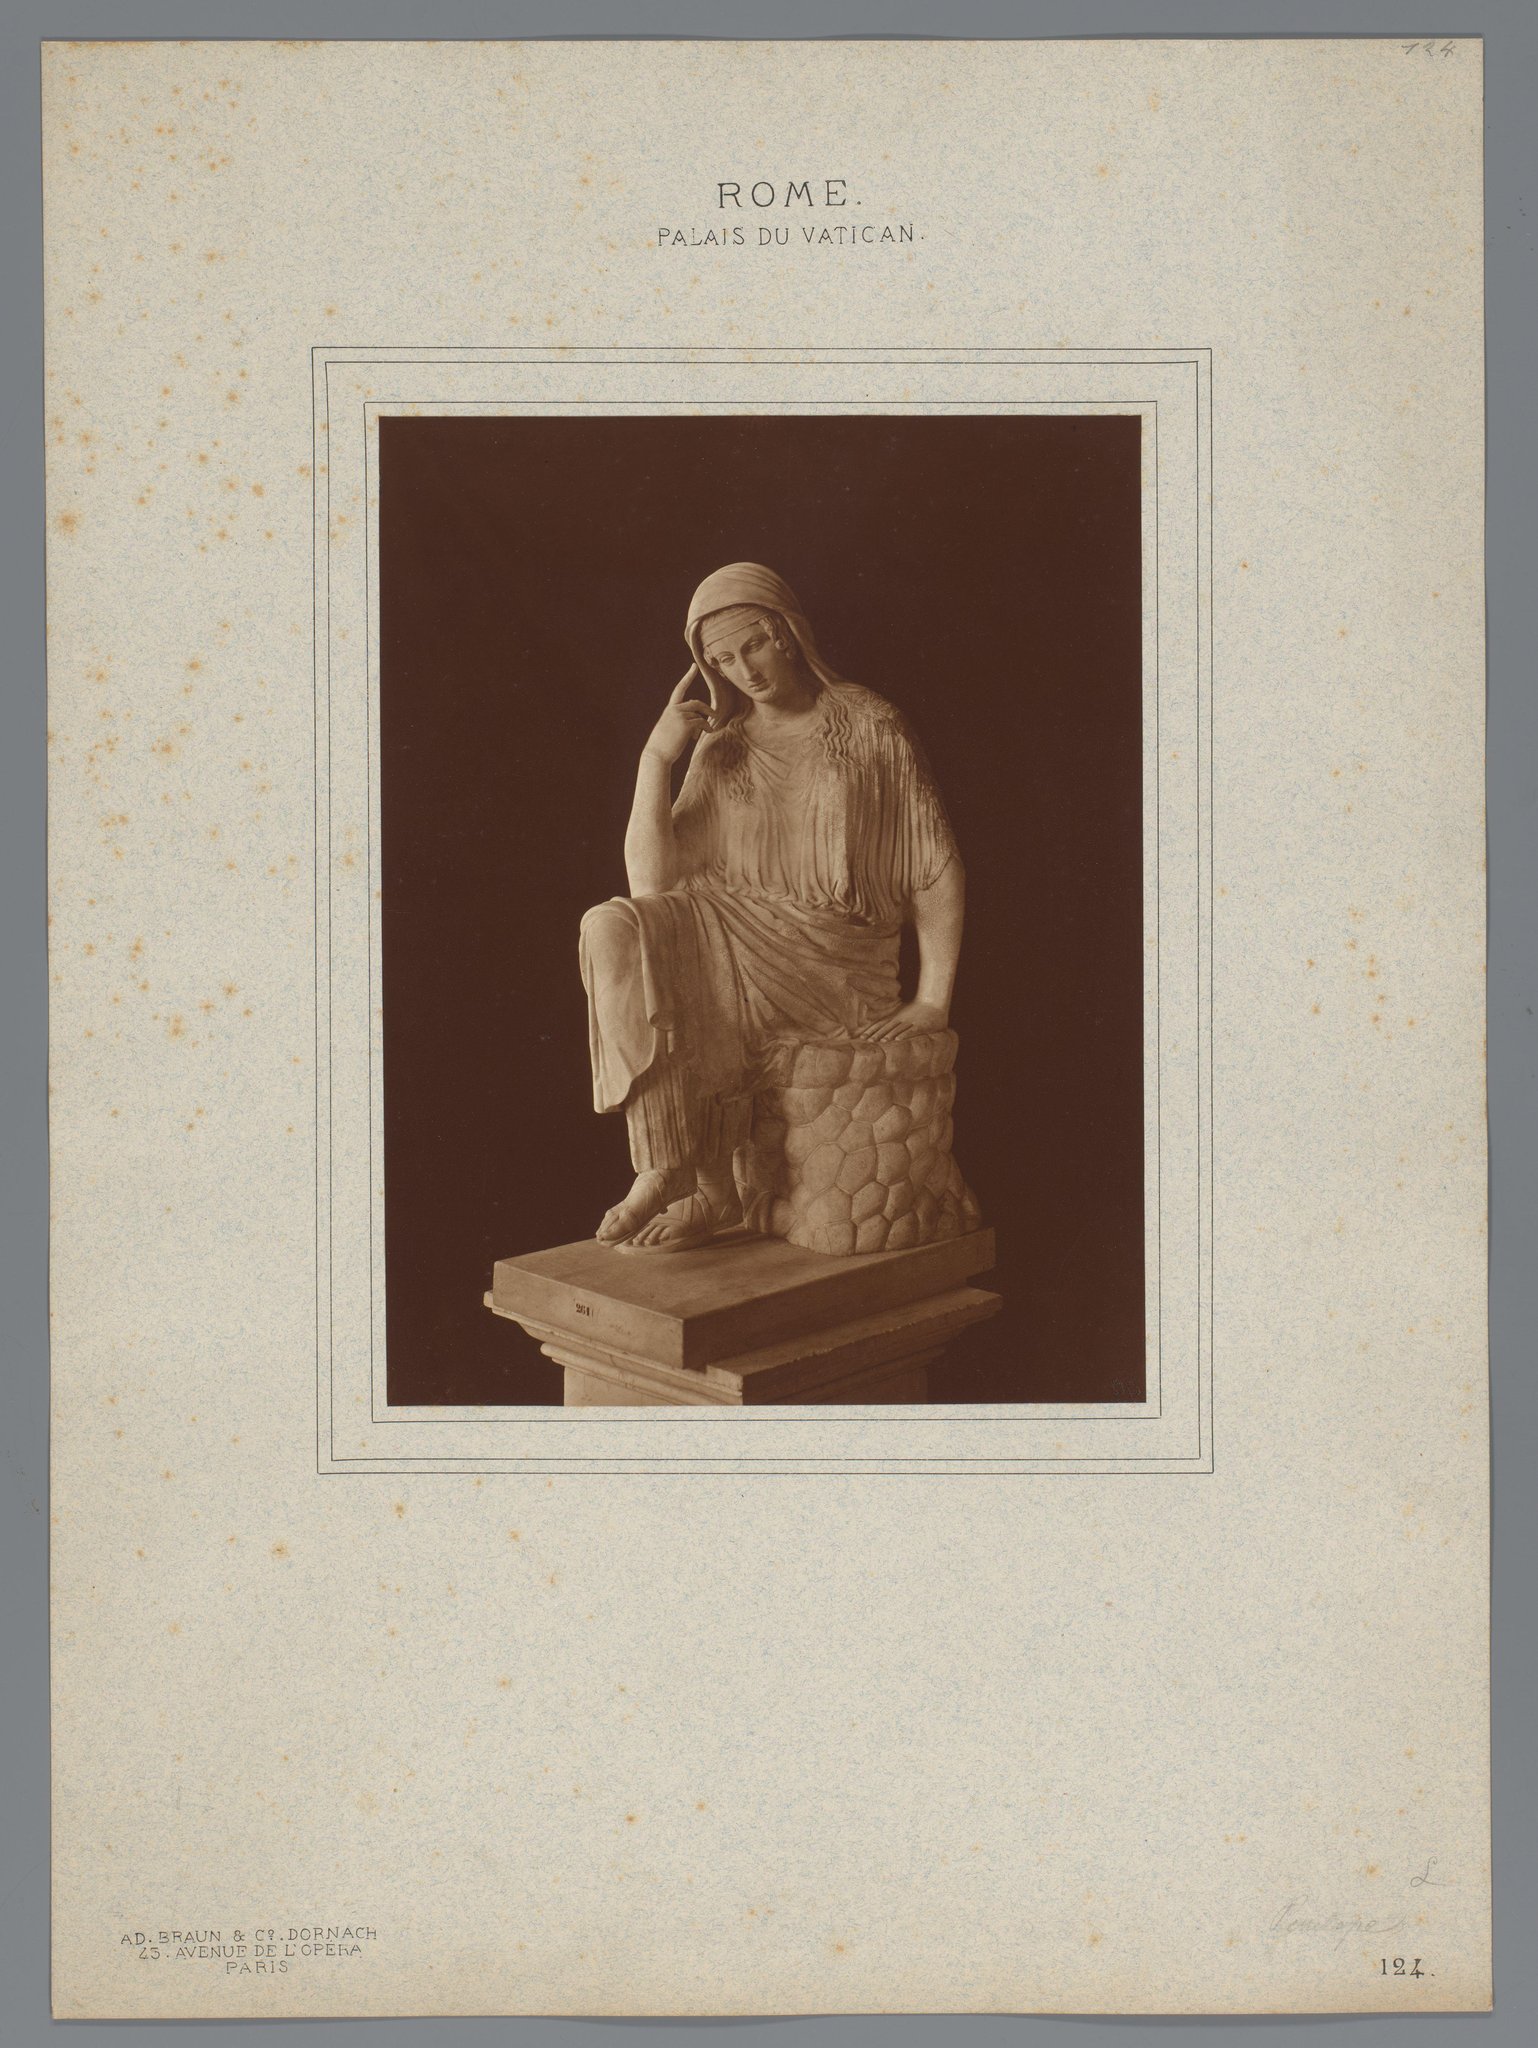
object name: photograph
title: Sculptuur van Penelope (coll. Vaticaanse Musea)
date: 1880-1900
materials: cardboard, paper, photographic support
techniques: carbon print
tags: penelope